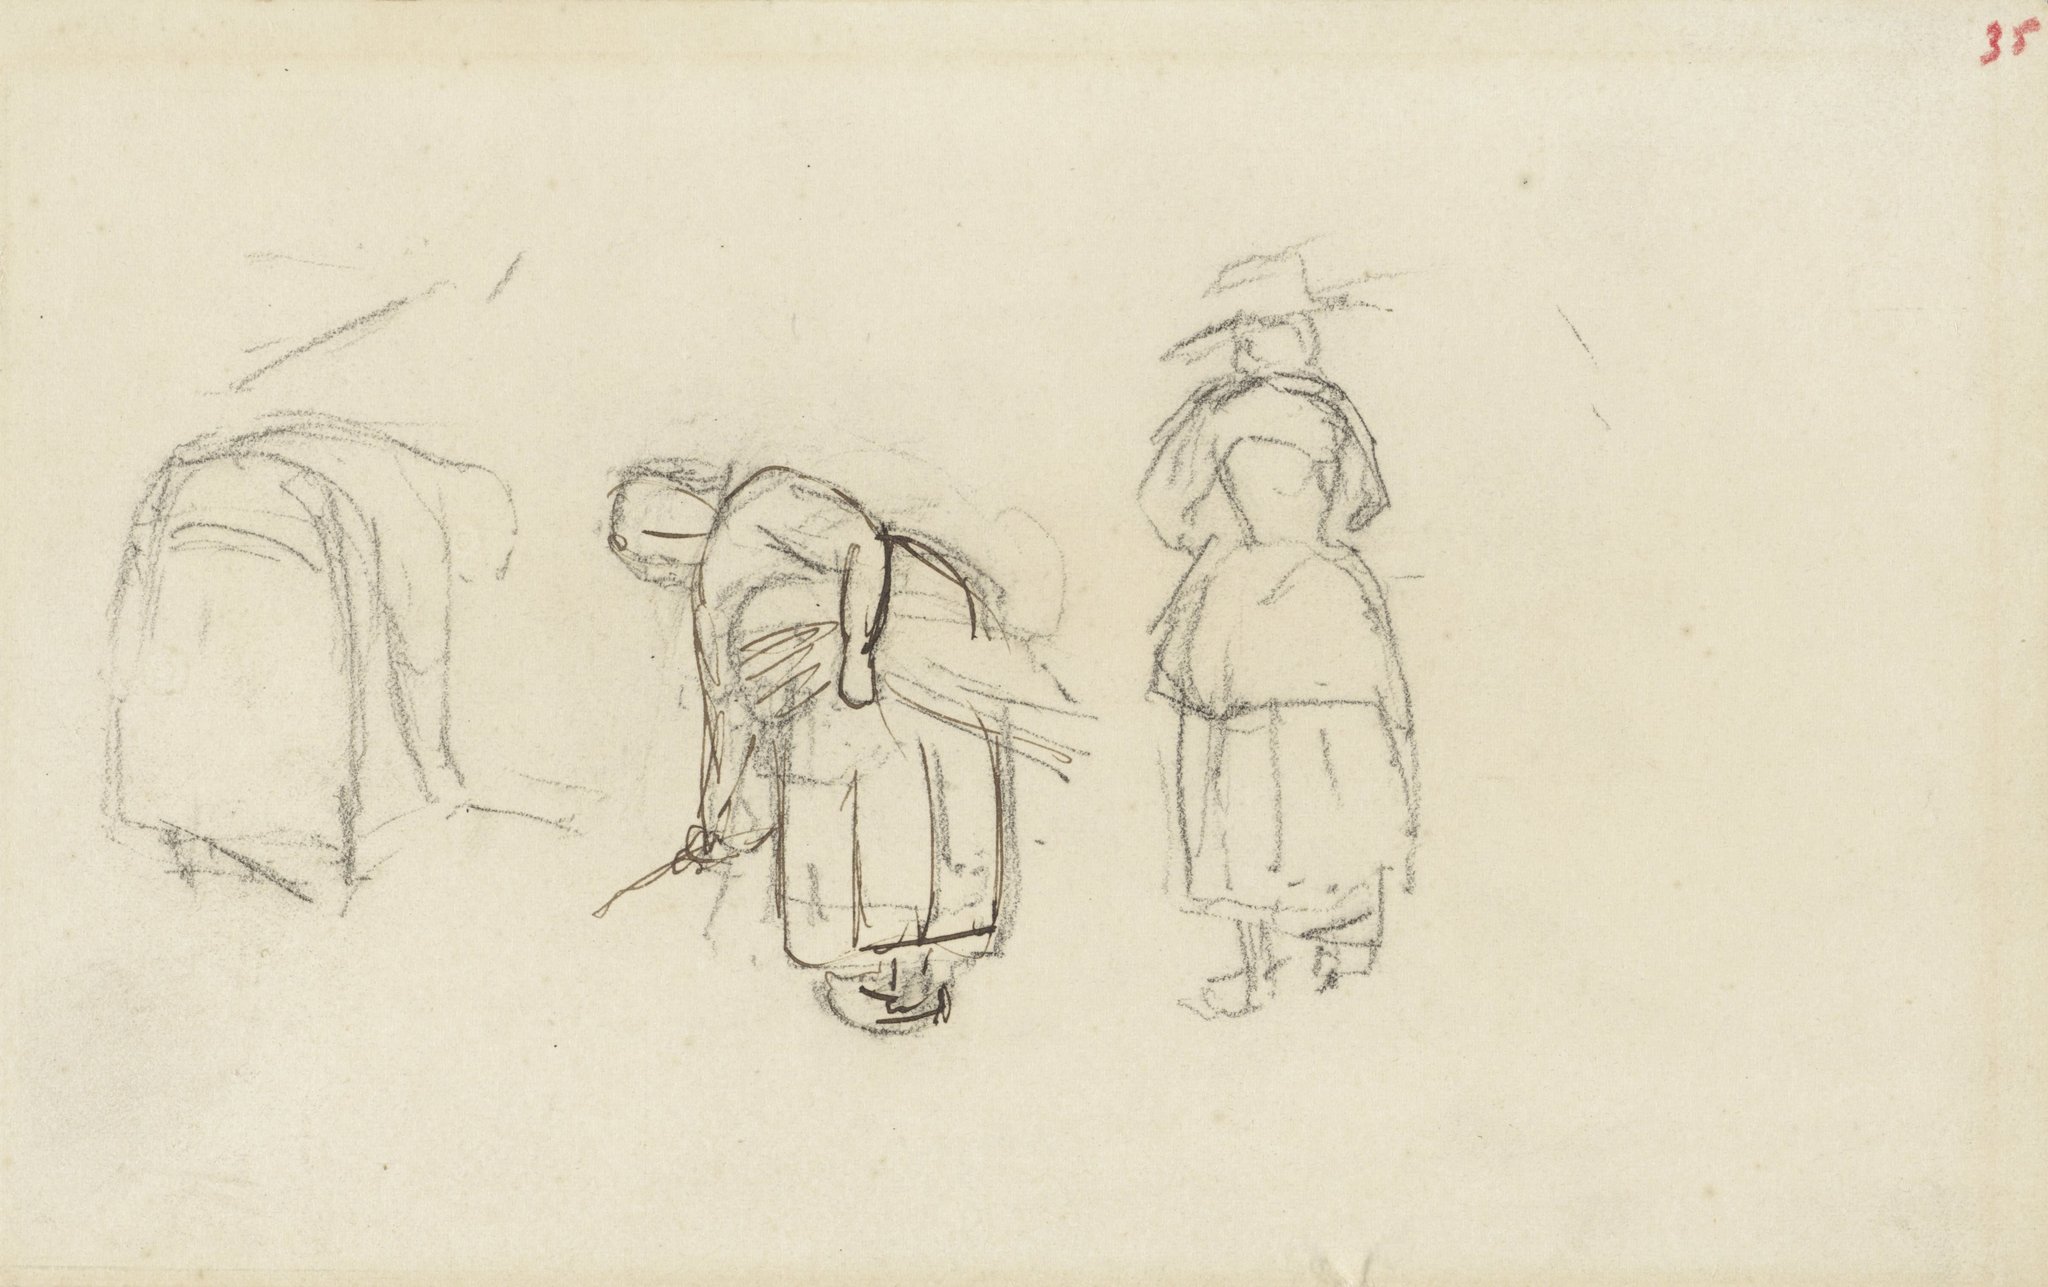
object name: drawing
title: Drie studies van een werkende vrouw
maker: jozef israëls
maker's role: draughtsman, painter, print maker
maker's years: 1824-1911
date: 1834-1911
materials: chalk, ink, paper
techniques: pen